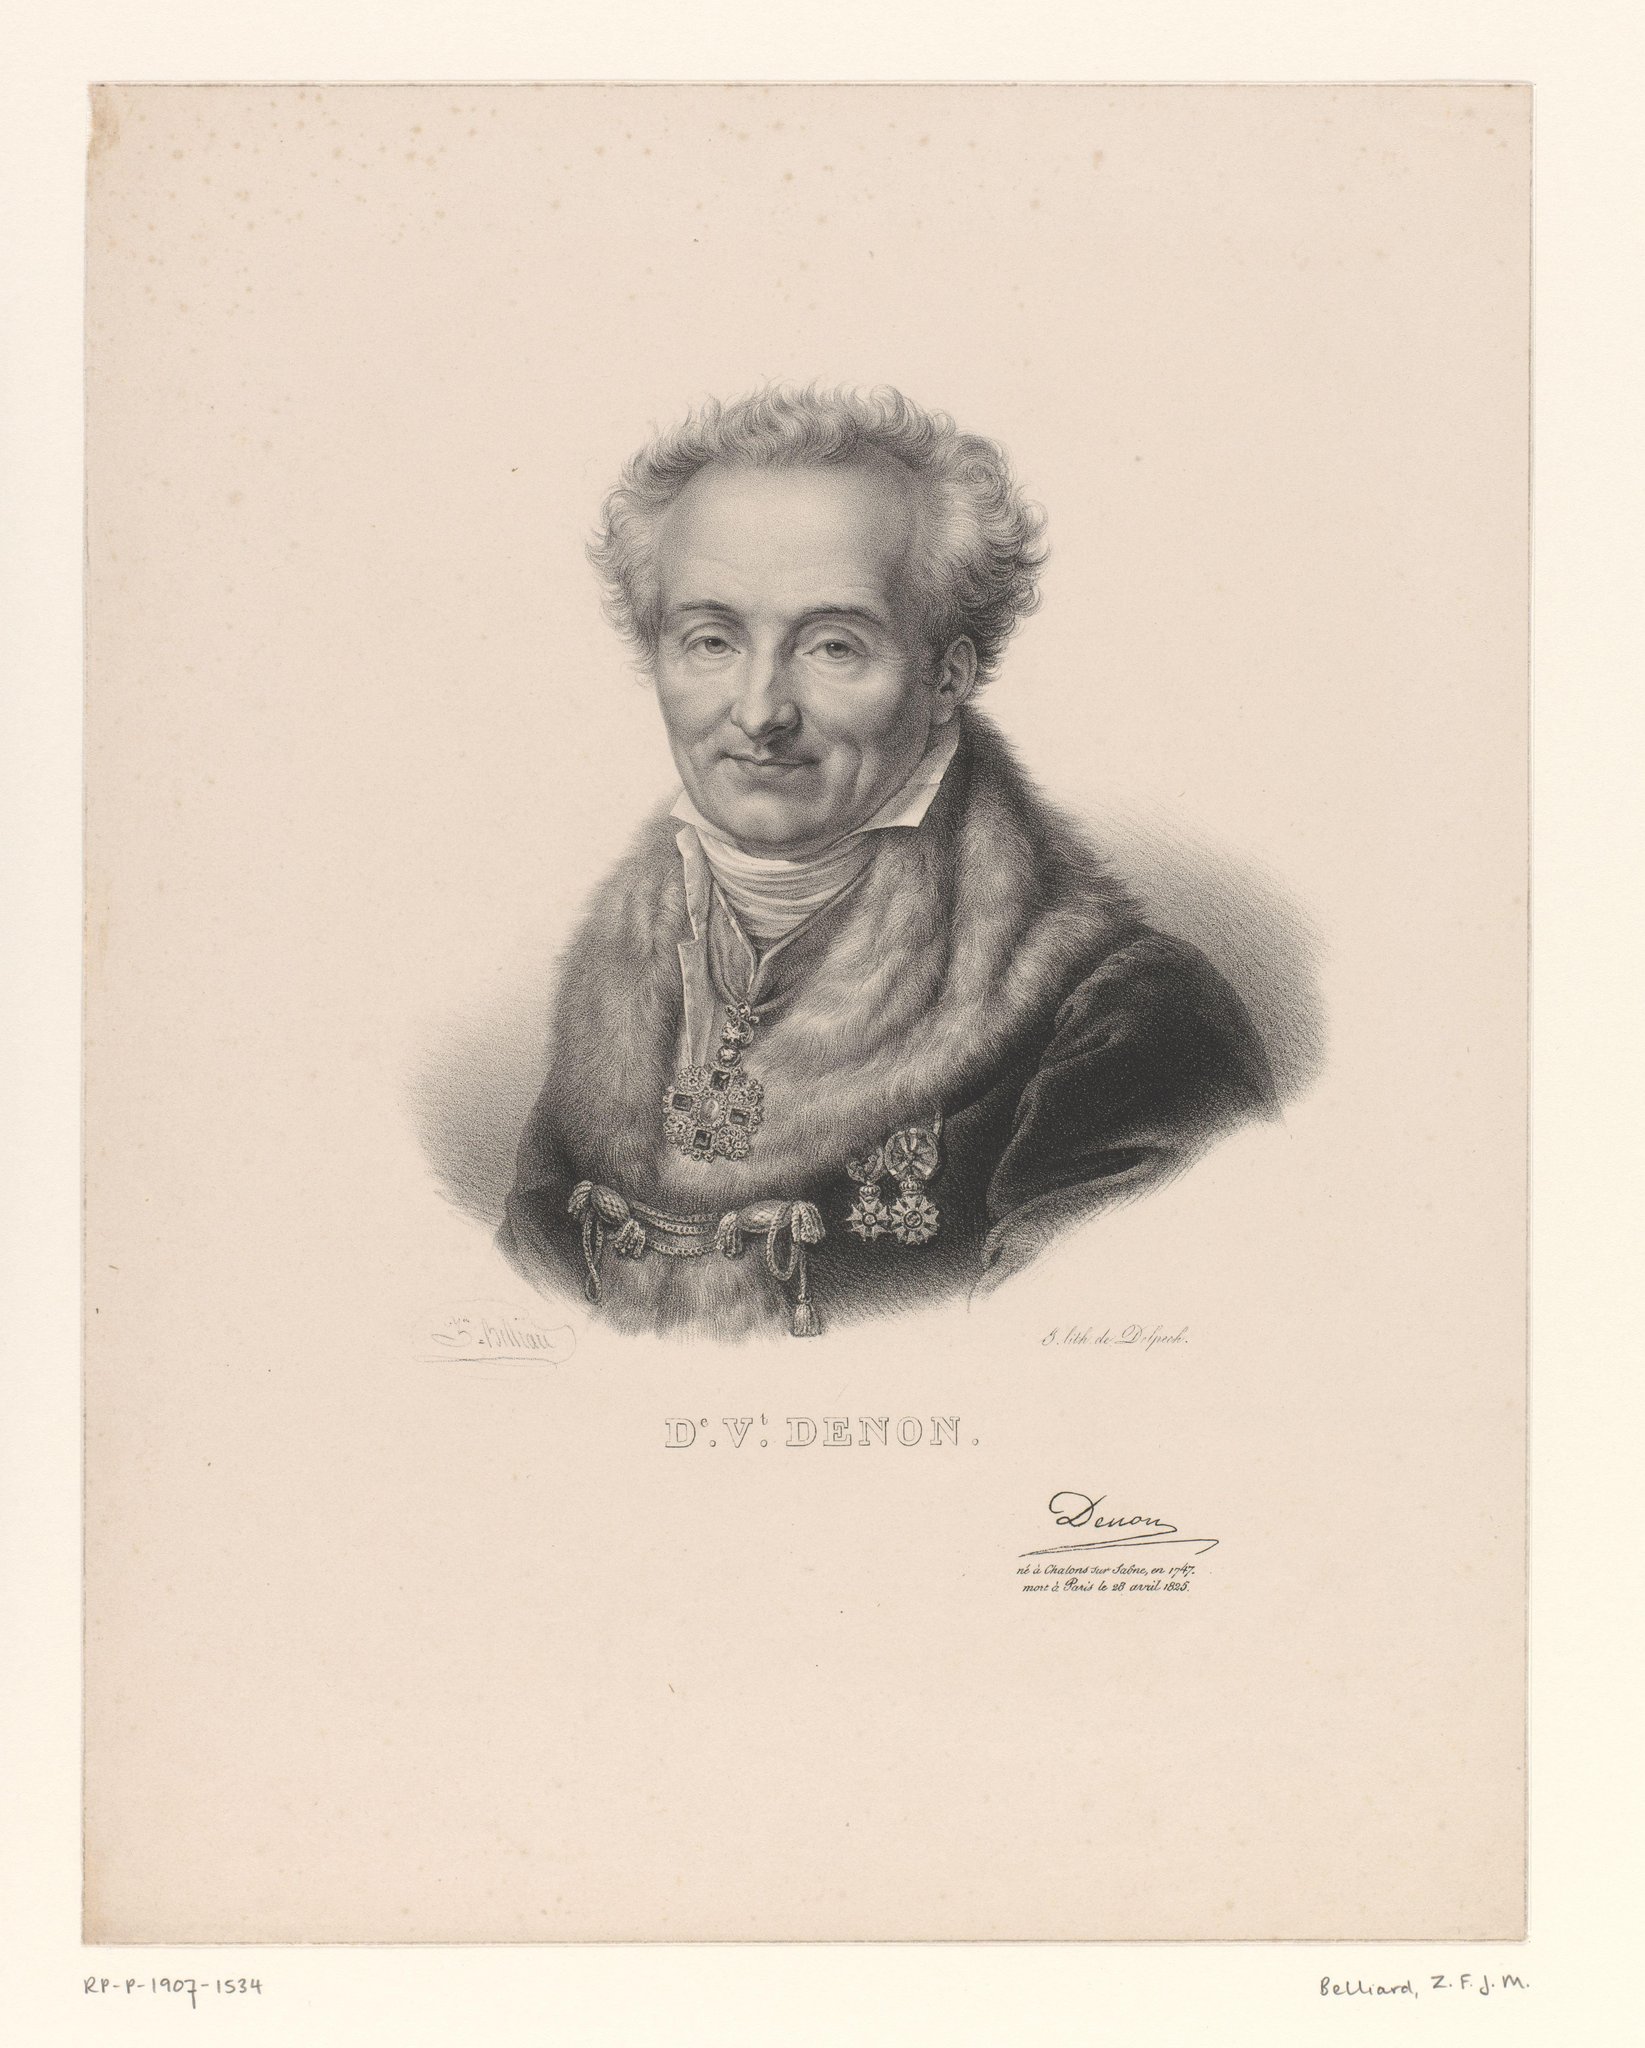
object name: print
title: De. Vt. Denon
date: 1830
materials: paper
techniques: lithograph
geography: paris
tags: paris, print maker, draughtsman, dominique vivant denon (baron), historical persons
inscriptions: collector's mark: Lugt 2228a